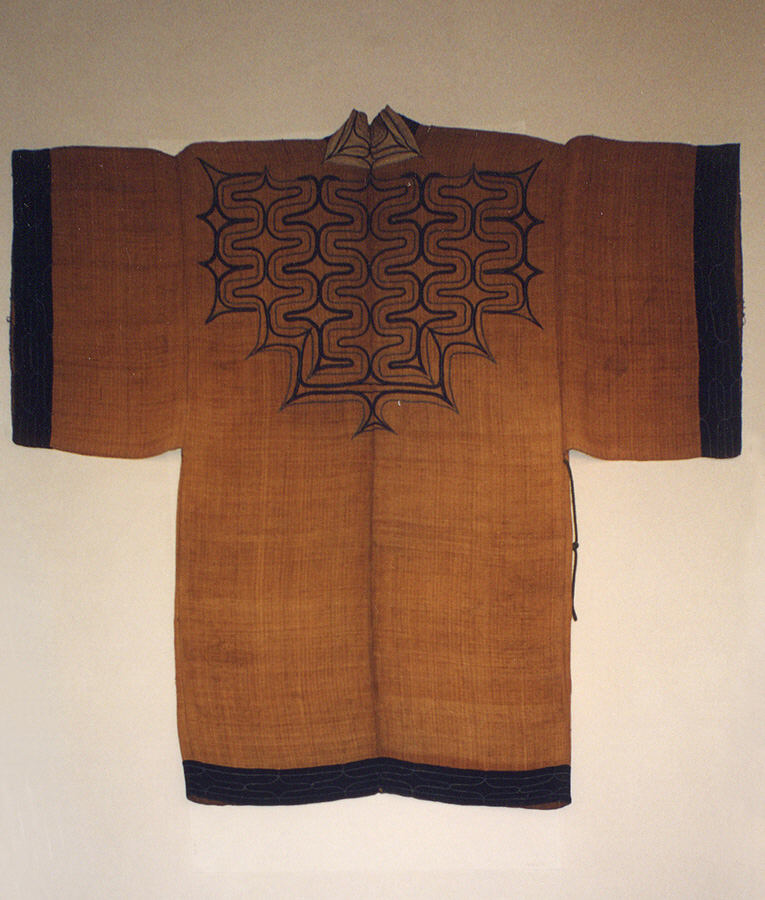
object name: robe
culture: japanese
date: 1801-1900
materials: wood, fiber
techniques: embroidery